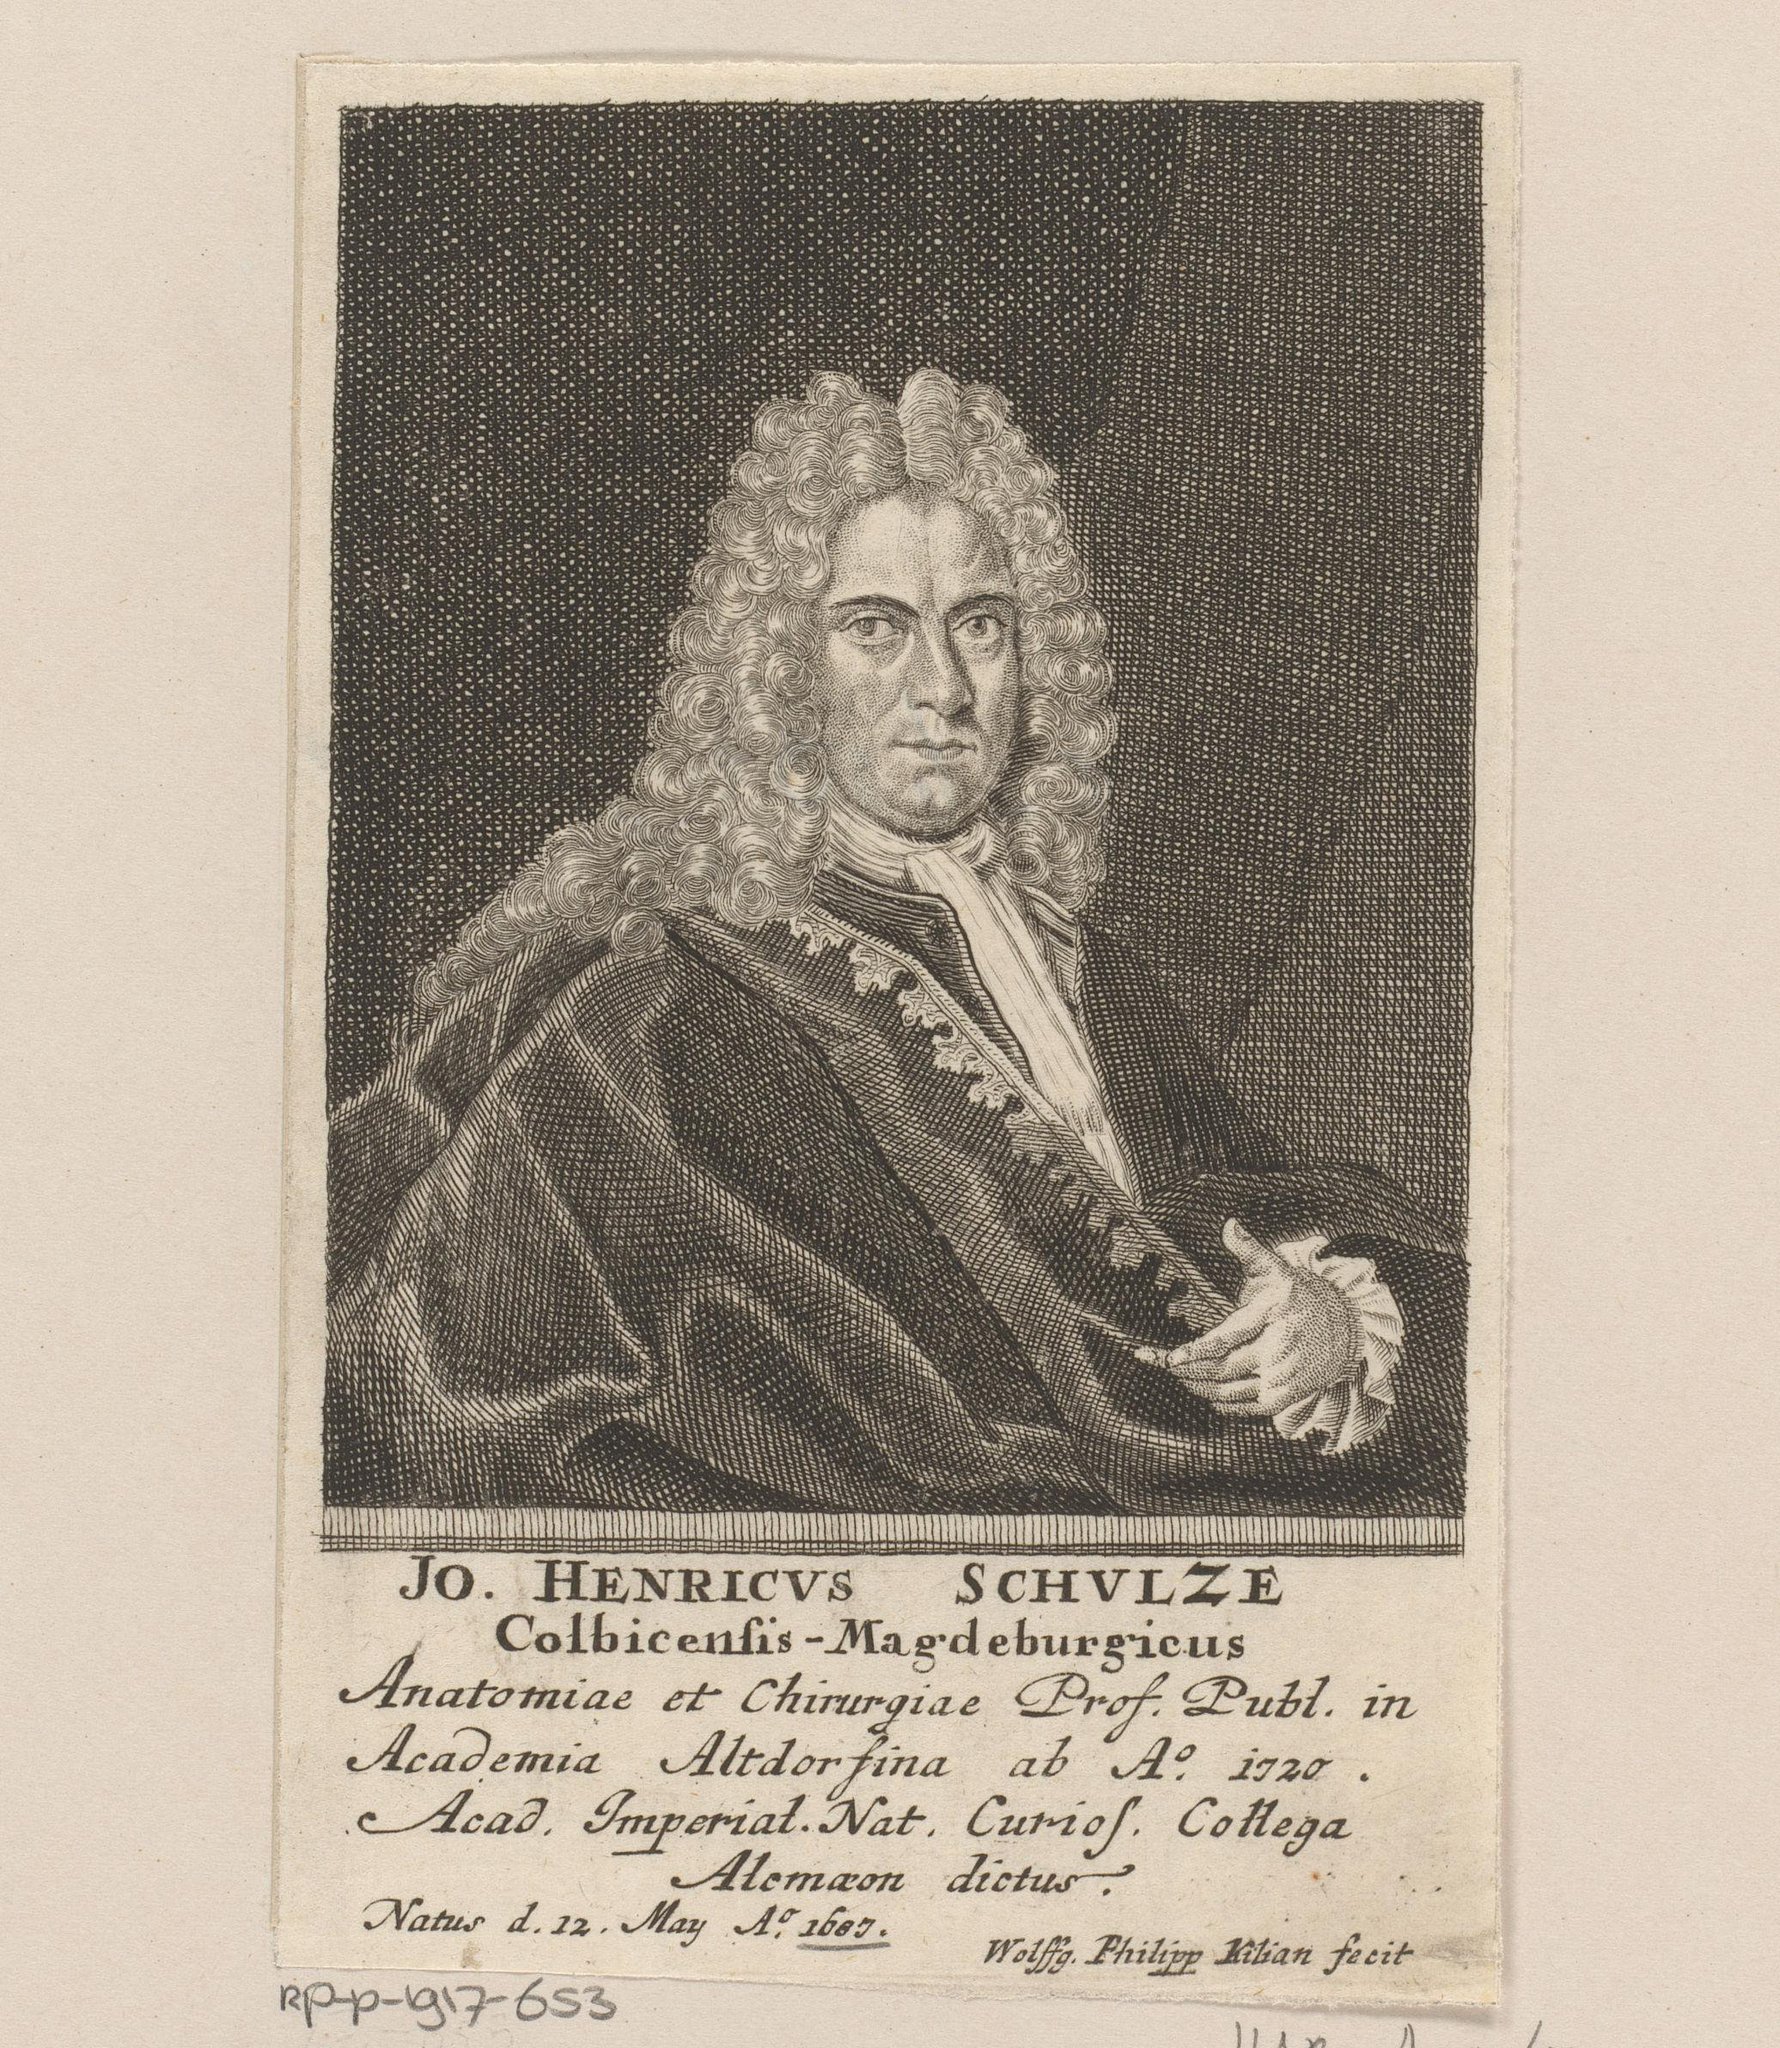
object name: print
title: Portret van Johann Heinrich Schulze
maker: wolfgang philipp kilian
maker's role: artist, draughtsman, print maker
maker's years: 1654-1732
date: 1728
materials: paper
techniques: engraving, etching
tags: halle, historical persons, physician, doctor, professor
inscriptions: collector's mark: Lugt 2228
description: Prent waarschijnlijk uit: Baier, Johann Jacob. Biographiae professorum medicinae qui in Academia Altorfina unquam vixerunt. Neurenberg/Altdorf: erven Johann Daniel Tauber, 1728.